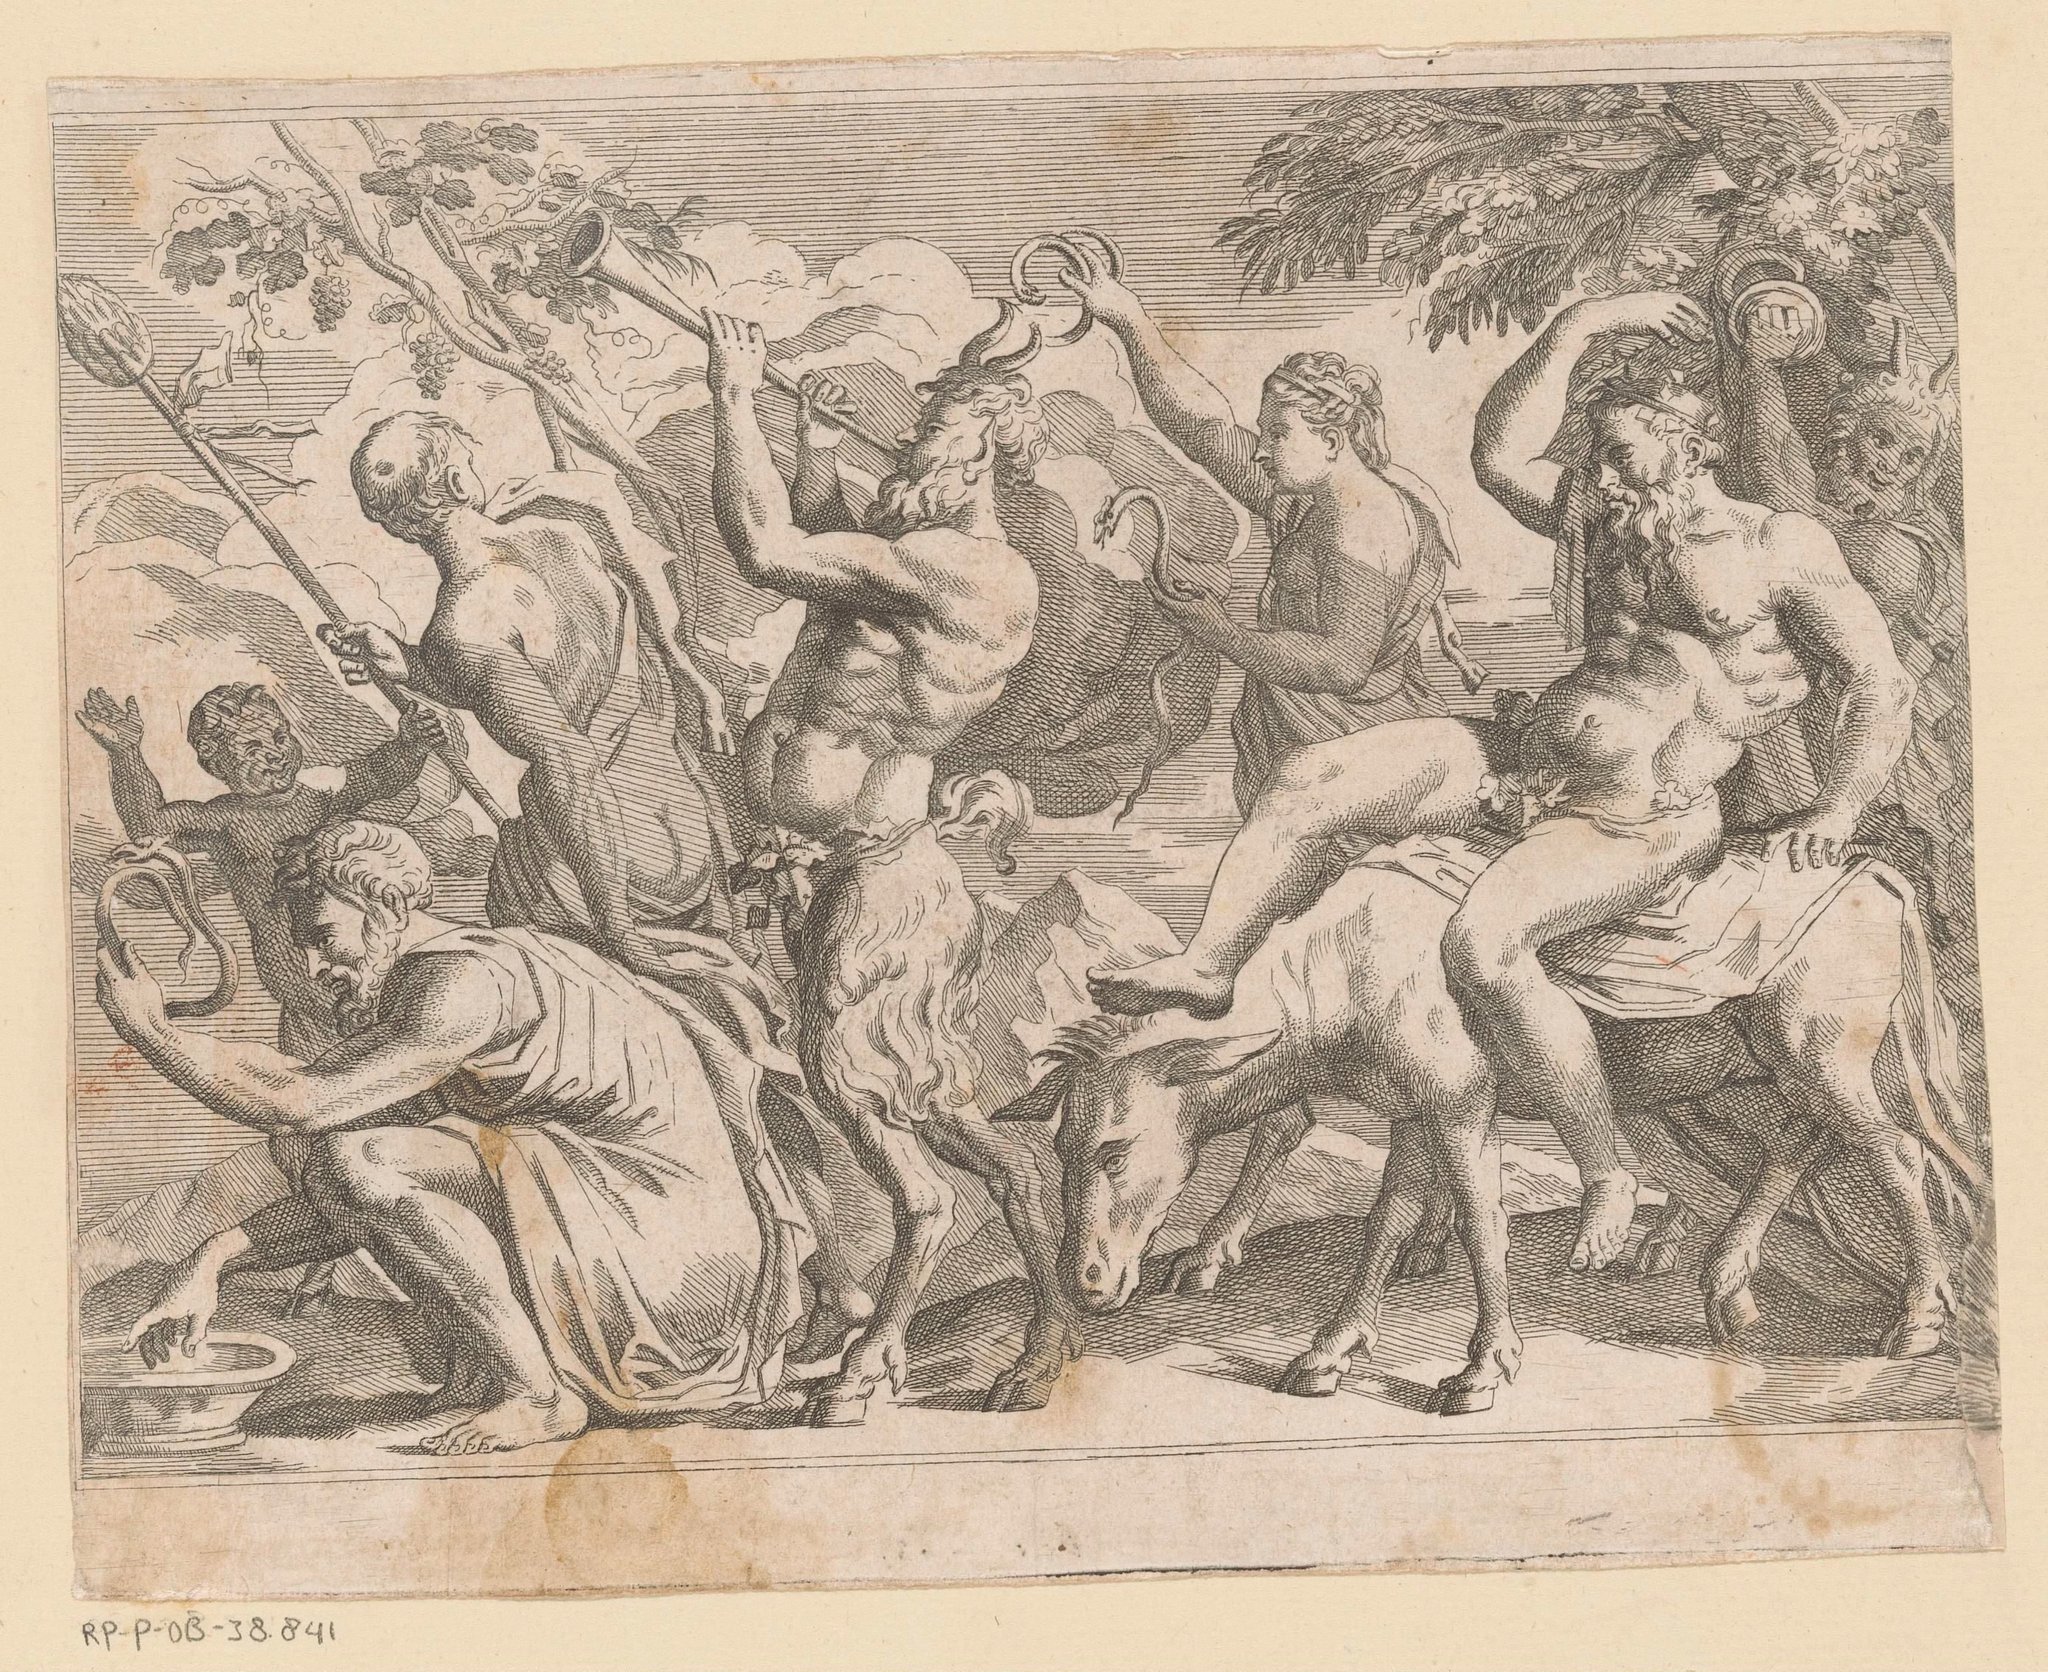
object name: print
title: Silenus met saters en maenaden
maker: Anonymous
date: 1650-1699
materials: paper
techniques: etching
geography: italy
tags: thyrsus ~ attribute of bacchus, maenad(s), female bacchant(es), male bacchant(es), (story of) silenus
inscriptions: collector's mark: Lugt 240, inscription: ‘6,1. - 43, w.’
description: Een optocht met Silenus zittend op de rug van een ezel. Voor Silenus lopen een sater met een thyrsus in de hand, een sater blazend op een trompet, en een sater en een maenade met slangen.